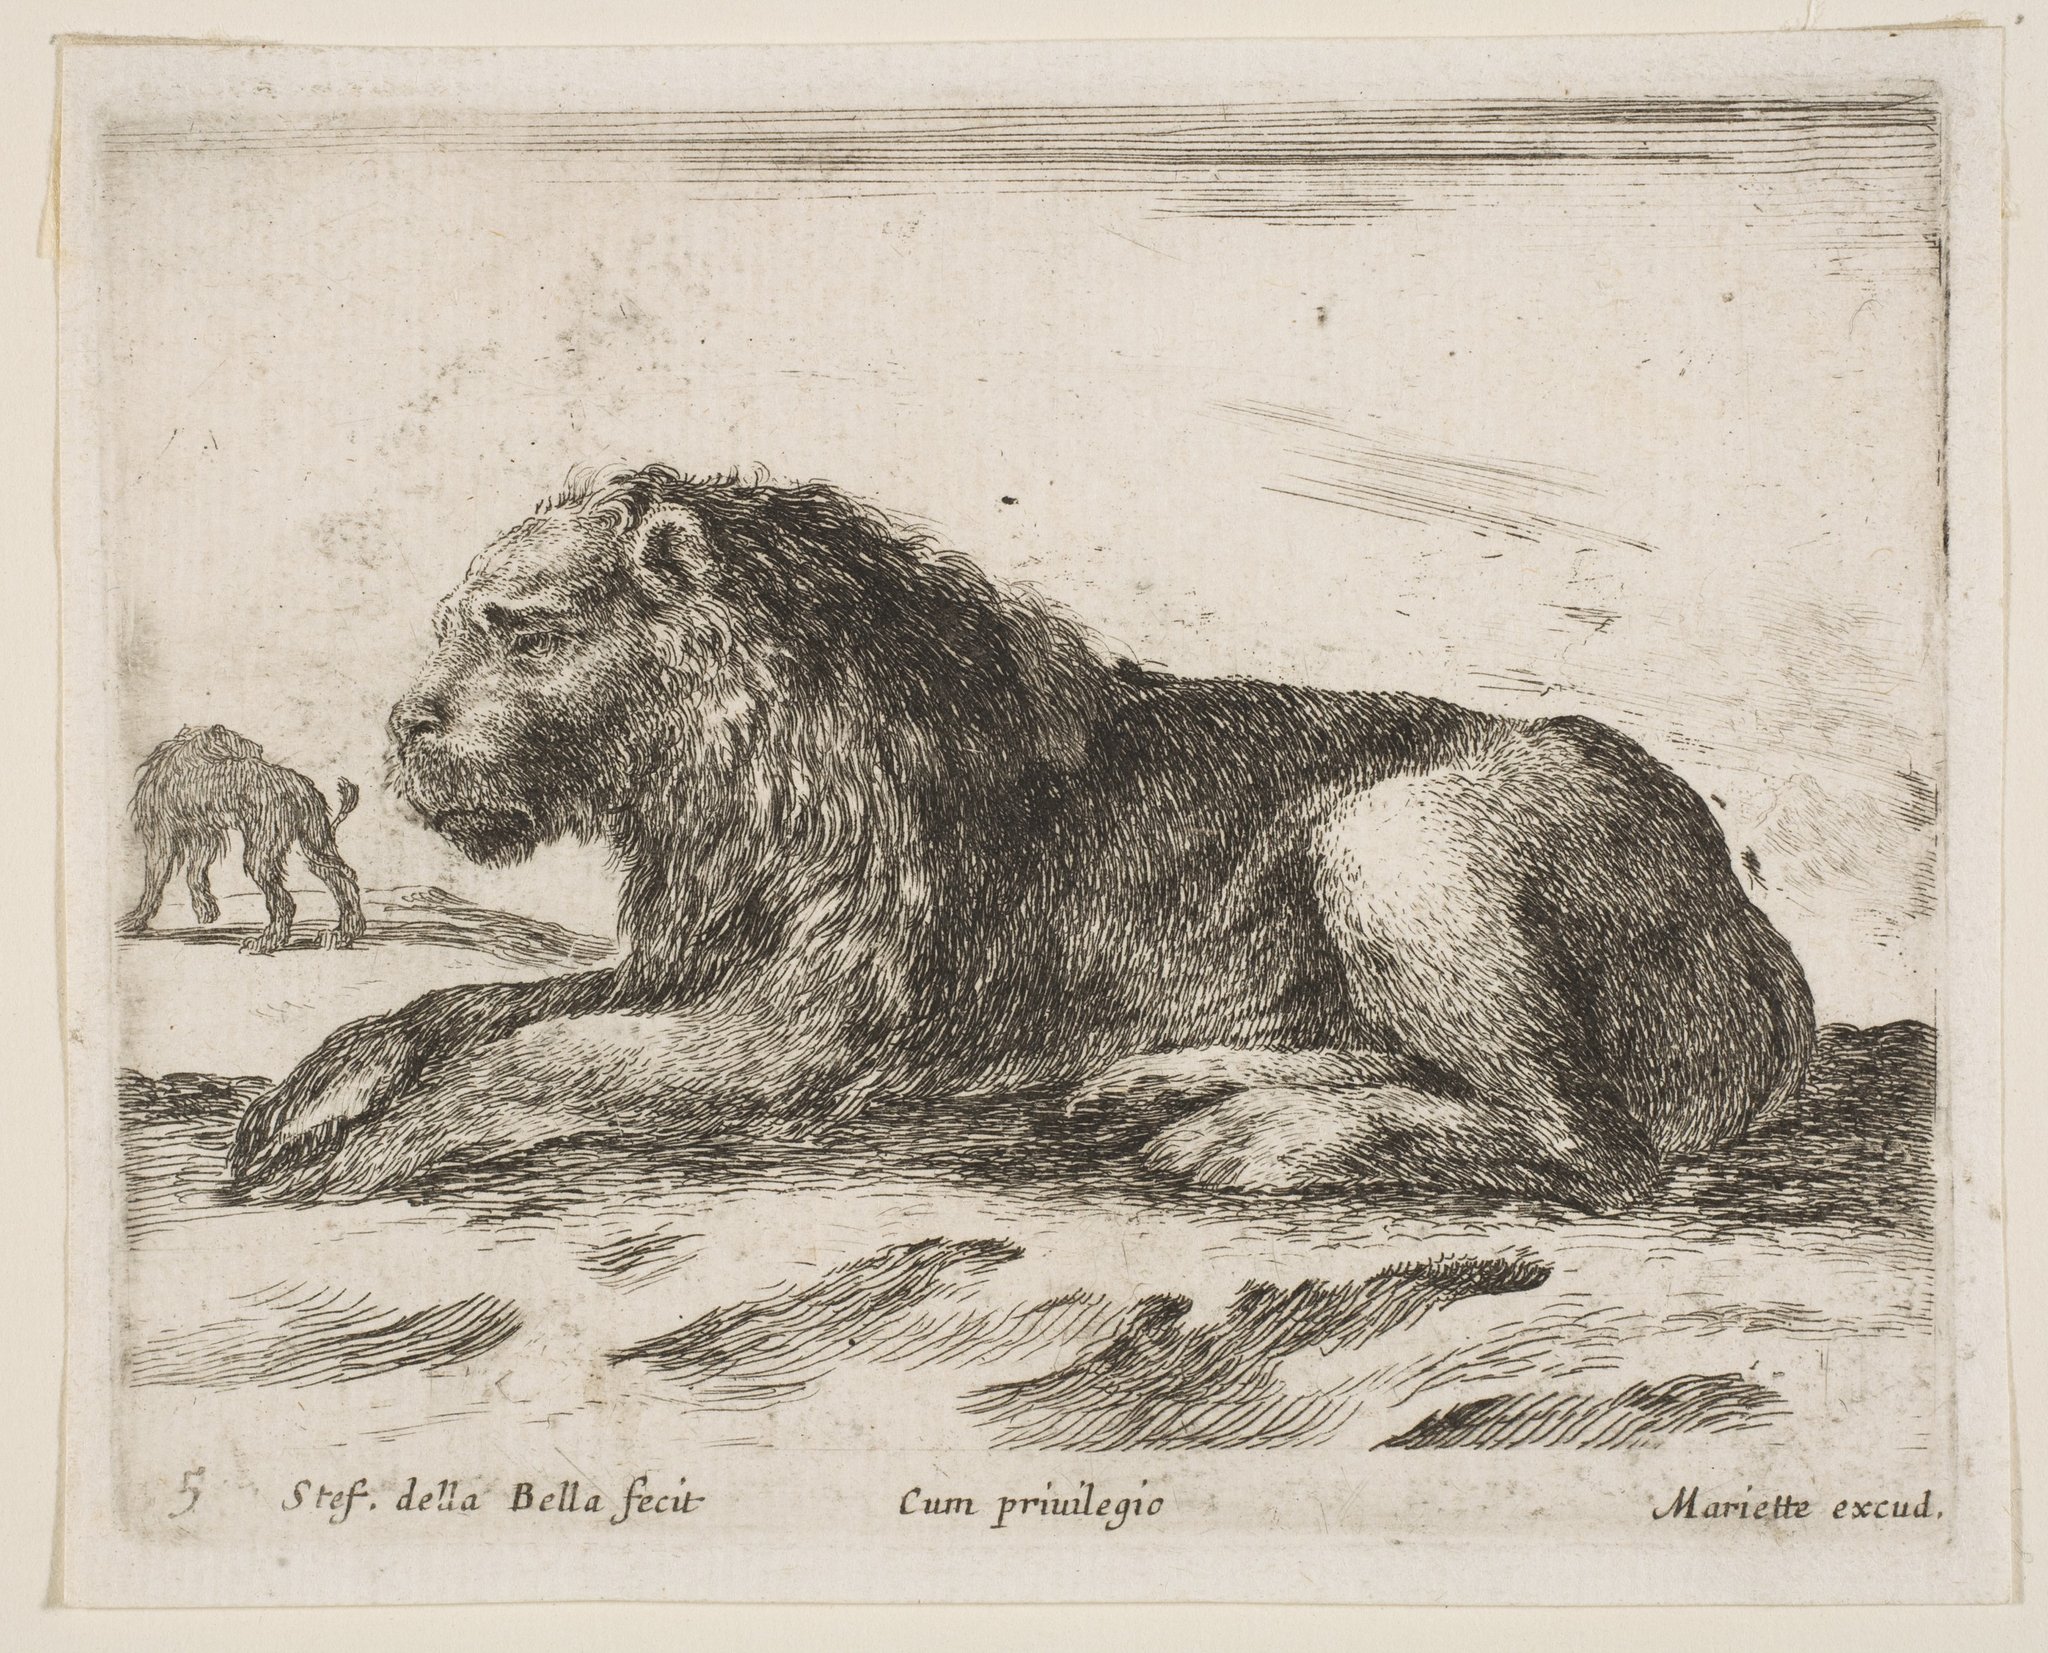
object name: print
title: Reclining lion, plate 5 from "Various Animals" (Diversi Animali)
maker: stefano della bella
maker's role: artist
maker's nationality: italian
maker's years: 1610-1664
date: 1641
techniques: etching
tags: lions